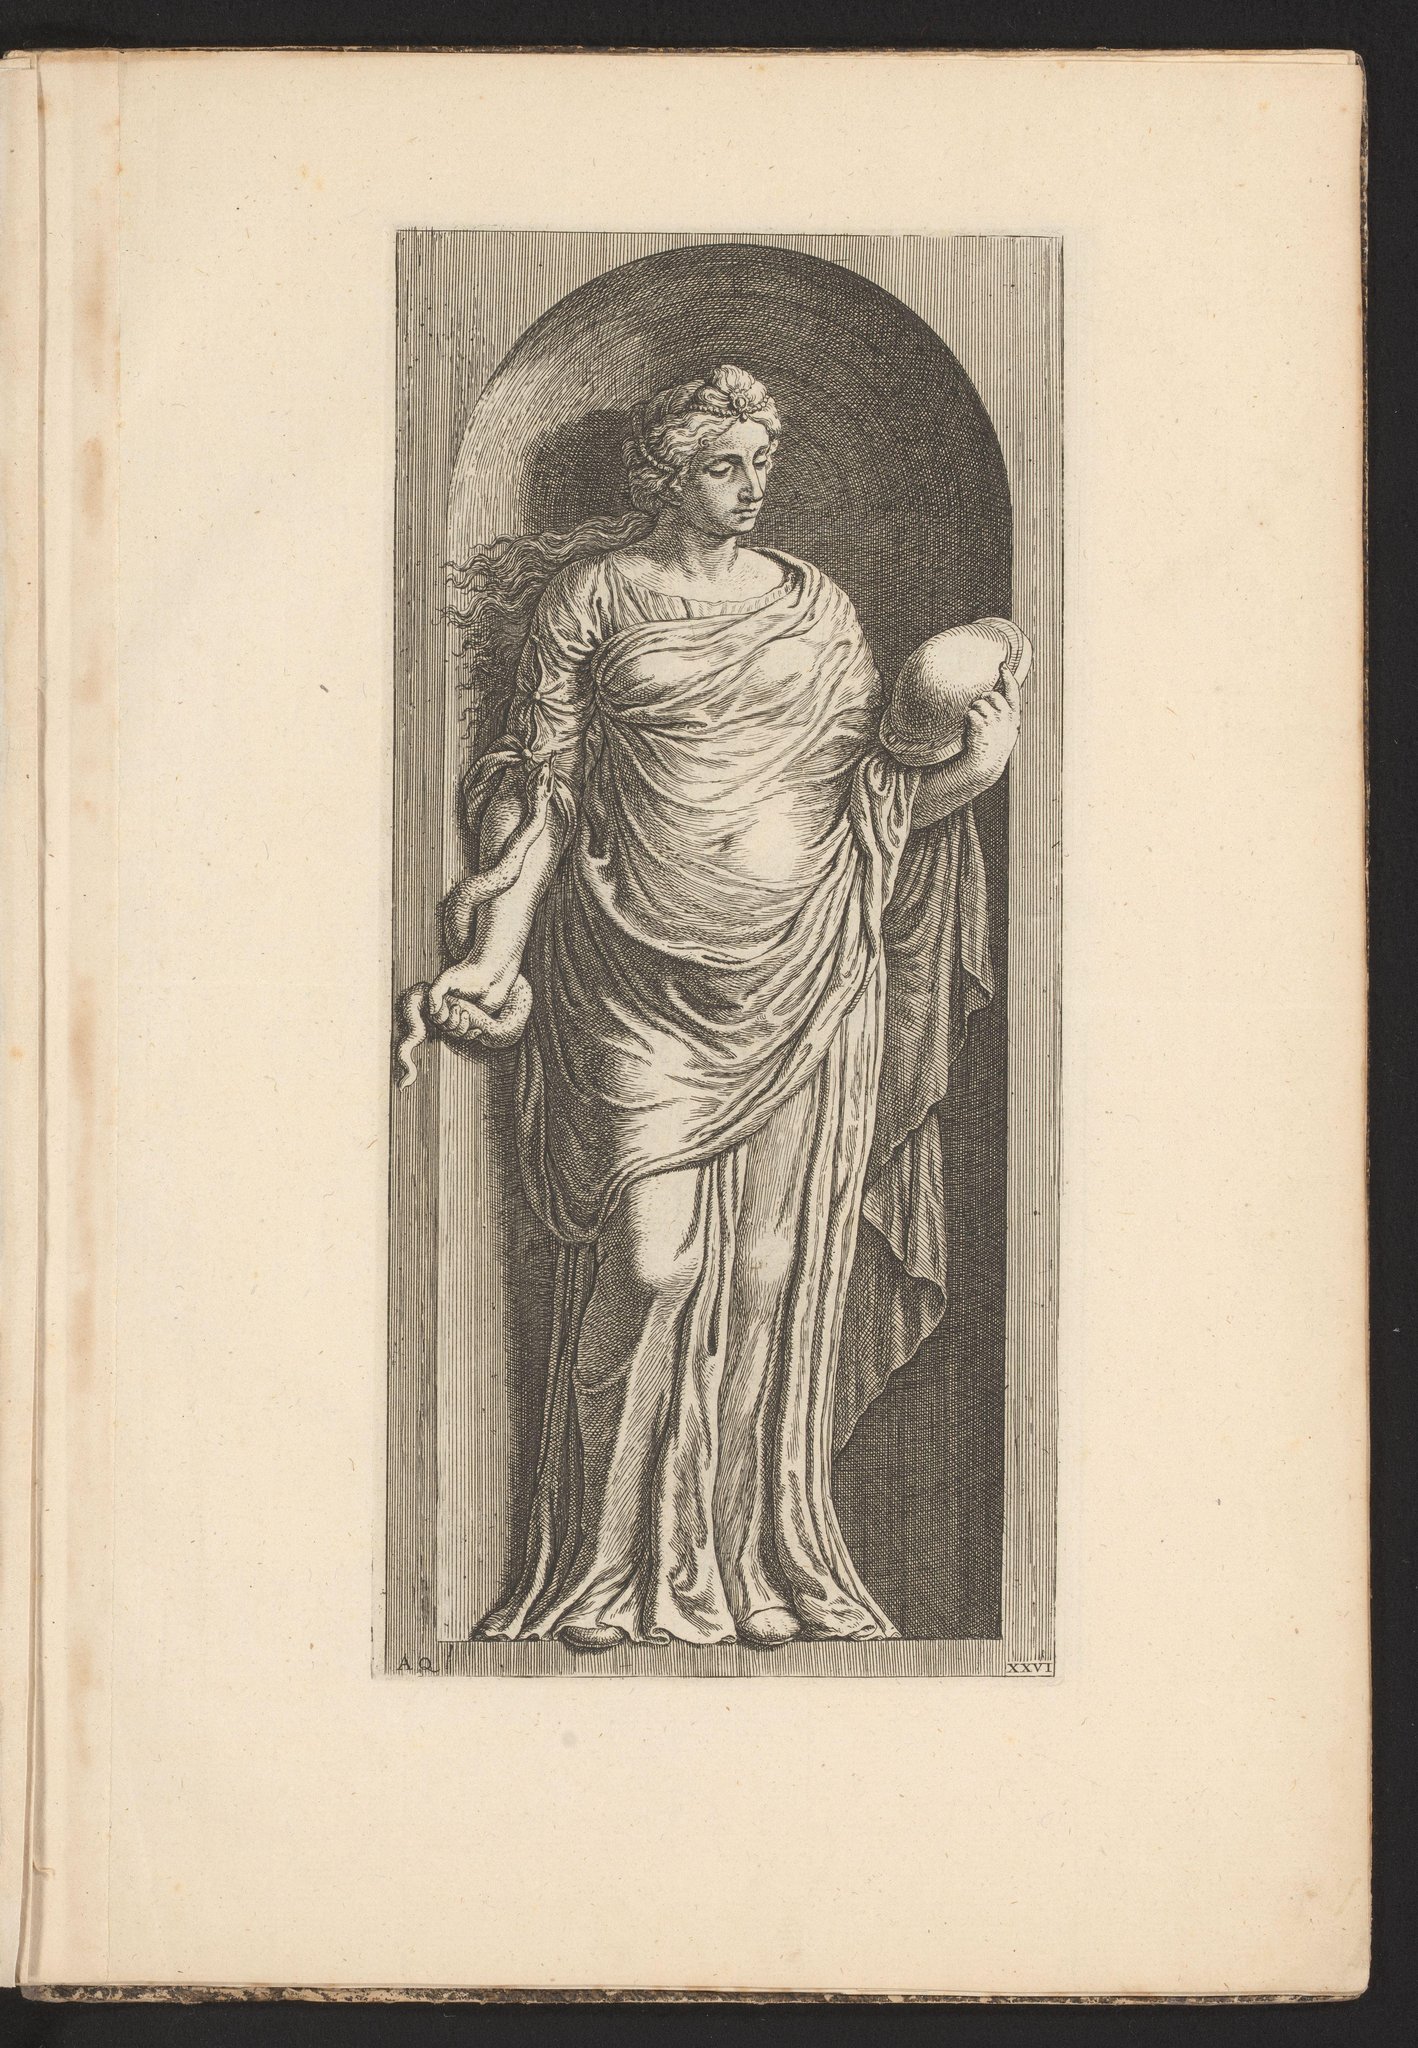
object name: album leaf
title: Beeld van Voorzichtigheid (Prudentia) in de Vierschaar van het Stadhuis op de Dam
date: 1719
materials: paper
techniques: engraving, etching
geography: amsterdam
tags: sculpture, prudentia (prudence) as roman personification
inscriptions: collector's mark: ‘Kunstnijverheidschool Quellinus Amsterdam Frans Halsstraat 14’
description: Prent waarschijnlijk uit: Architecture peinture et sculpture de la Maison de Ville d'Amsterdam, representee en CIX. figures en taille-douce (…). Amsterdam: David Mortier, 1719. Deze staat werd ook gebruikt in de uitgave van dit werk door Gerard Valck uit 1719, en in: Bouw schilder en beeldhouwkonst, van het Stadhuis te Amsteldam, vertoont in CIX figuuren (…). Amsterdam: Covens & Mortier & Covens Jr., s.a. (1774-1783). Een eerdere staat werd gebruikt in: Prima pars. Praecipuarum effigierum ac ornamentorum, amplissimae Curiae Amstelrodamensis (…). Amsterdam: Artus Quellinus (I), 1655. En in de editie uit 1665, uitgegeven door Frederik de Wit.